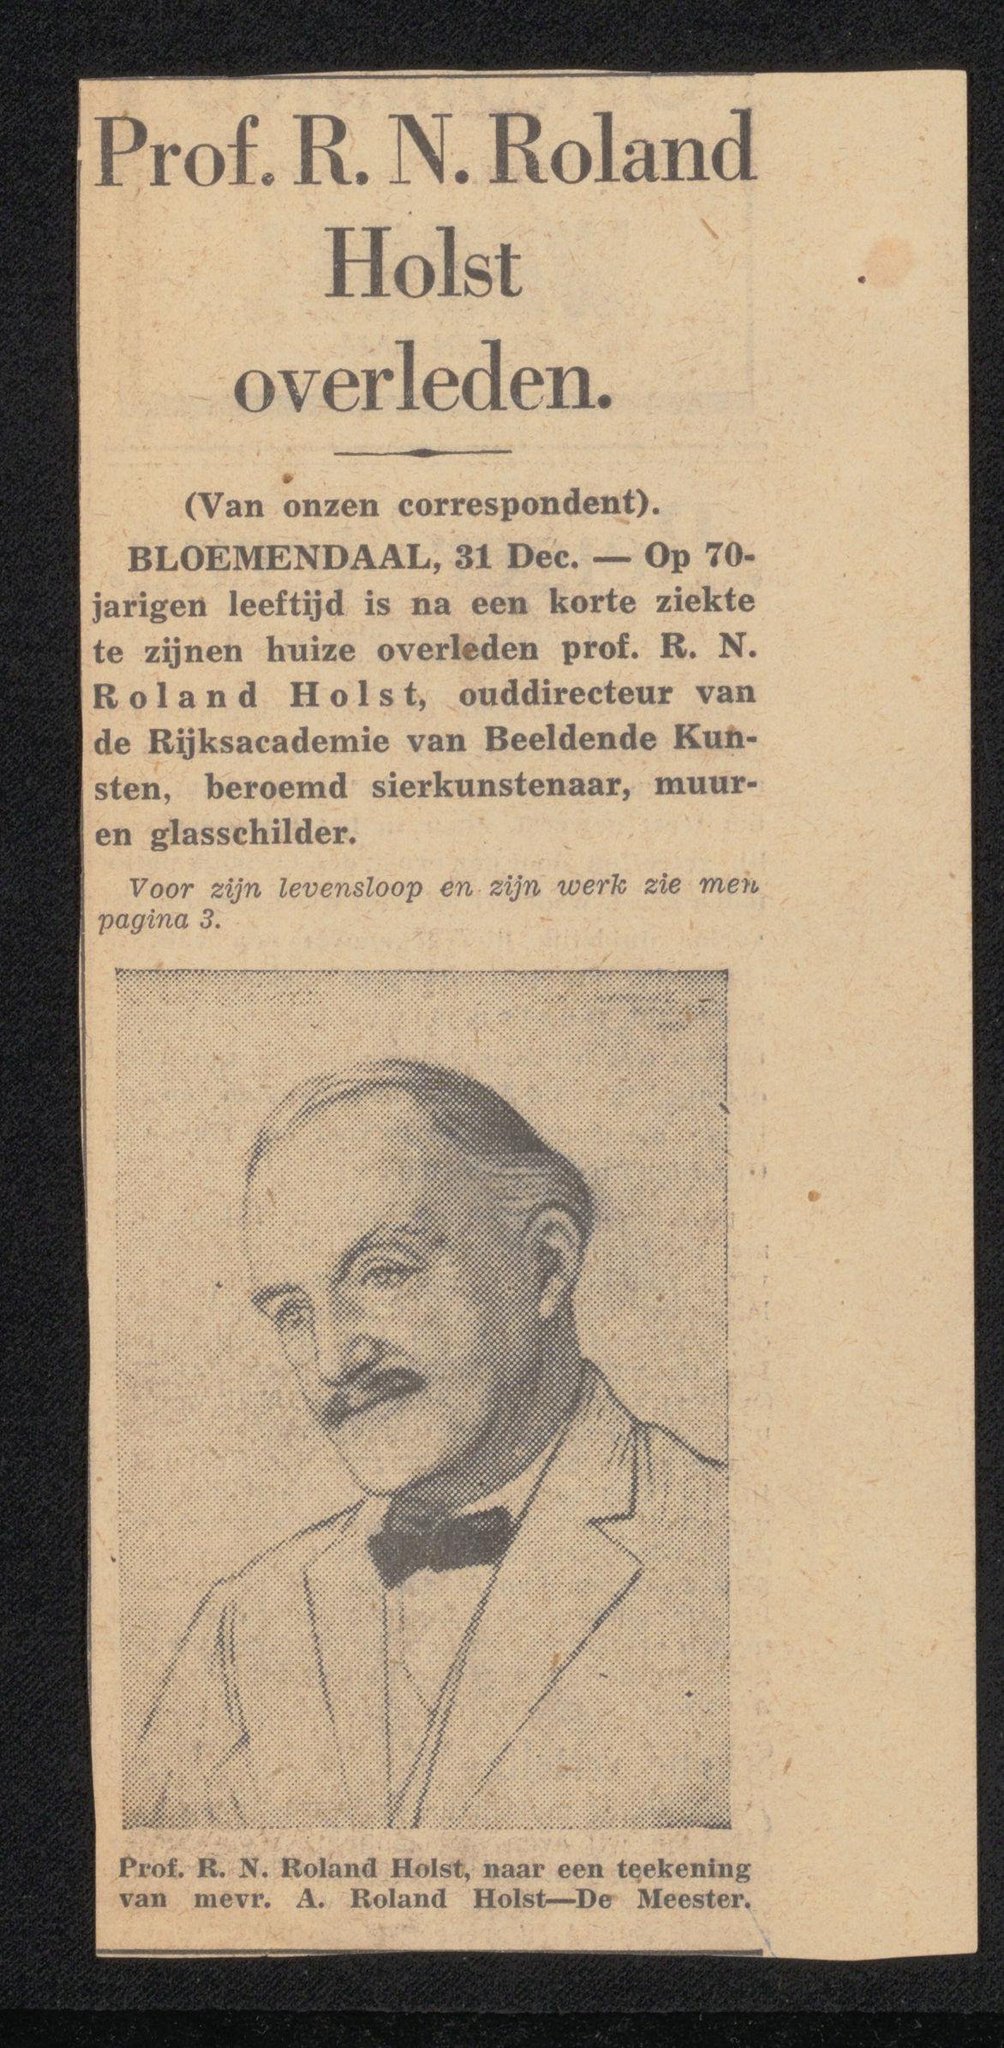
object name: newspaper clipping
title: Krantenknipsel betreffende Richard Roland Holst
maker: Anonymous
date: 1938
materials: paper, ink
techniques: printing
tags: richard nicolaüs roland holst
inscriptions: collector's mark: ‘RPK’